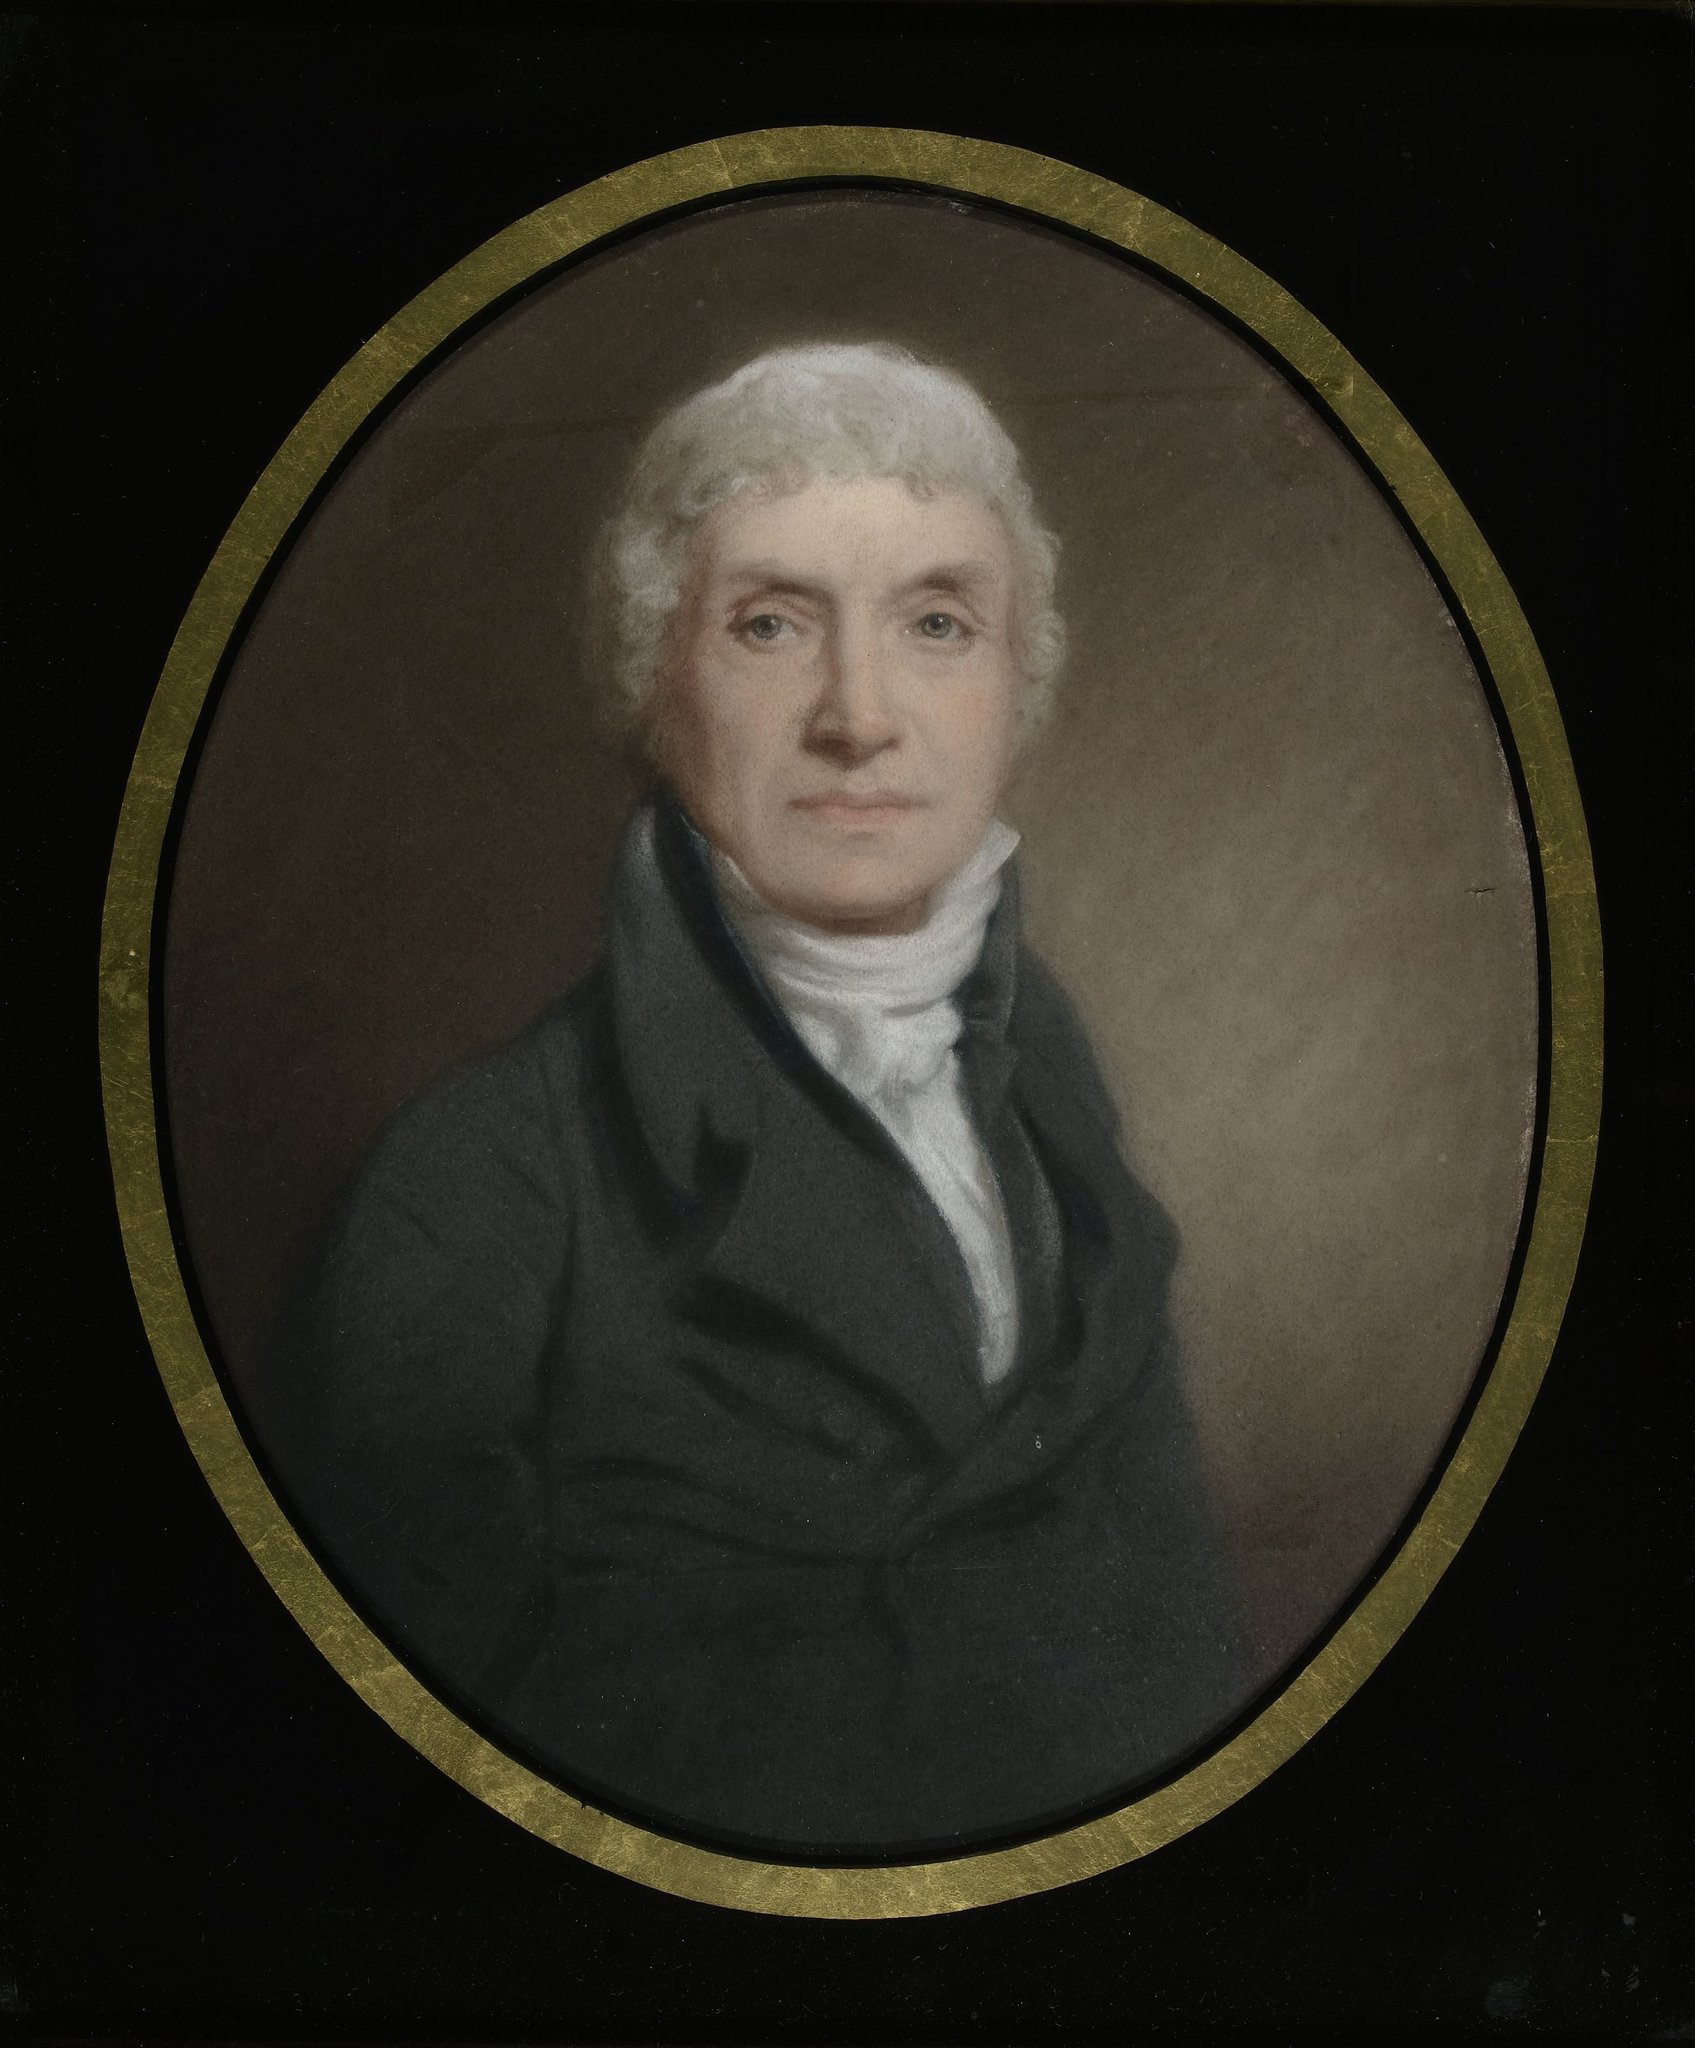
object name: pastel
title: Mr Johan Herman de Lange van Wijngaarden (1759-1818). Schepen van Haarlem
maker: charles howard hodges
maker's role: draughtsman, painter, print maker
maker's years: 1764-1837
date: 1800-1820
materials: parchment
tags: gouda, the hague, historical persons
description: Charles Howard Hodges (1764 - 1837). Jacob Carel Abbema and his second wife, Isabella Maria Smissaert. Pastels, c. 1813.